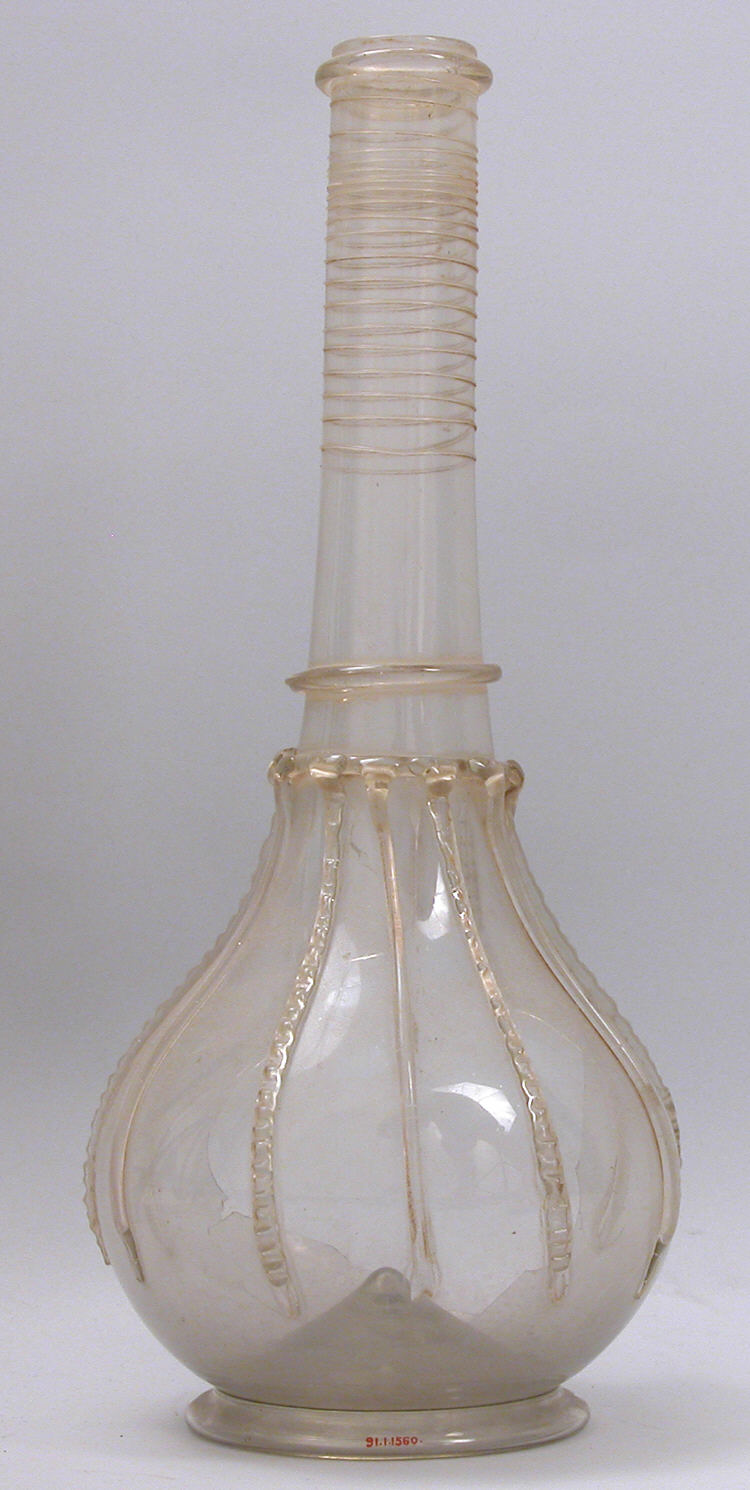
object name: bottle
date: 1701-1900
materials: glass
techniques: glassblowing, tooling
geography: iran